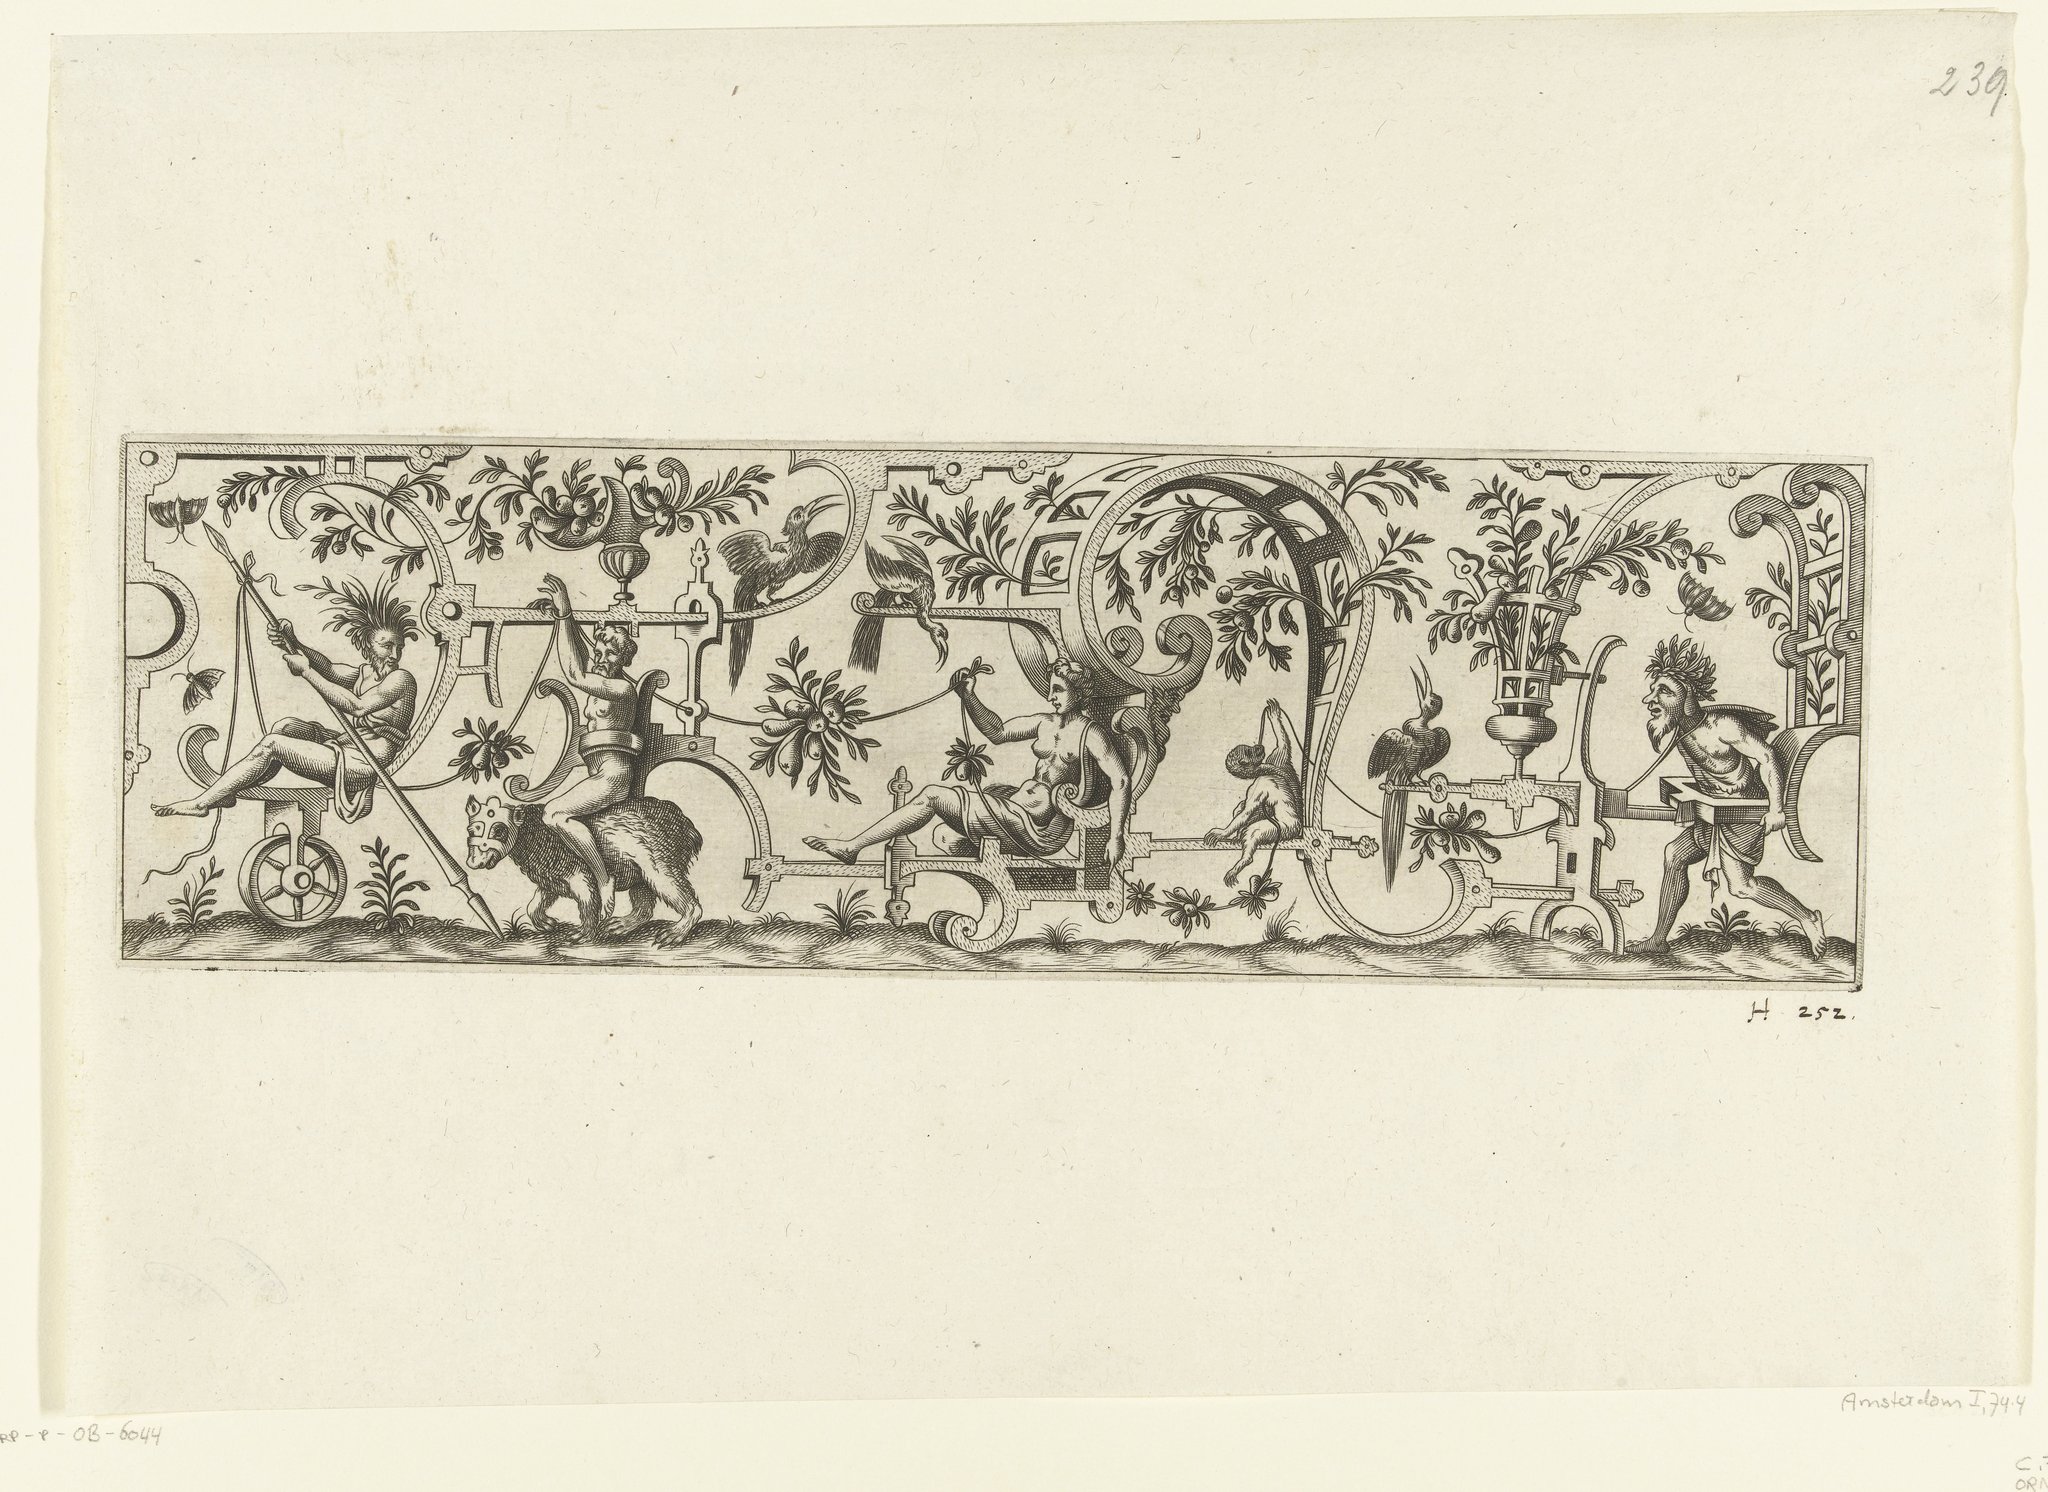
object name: ornament print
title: Wagen met een vrouw, geduwd door een man en getrokken door een man die op de rug van een beer rijdt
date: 1552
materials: paper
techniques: etching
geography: netherlands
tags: ornament ~ grotesque, chariot, triumphal car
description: Voorop zit een man met een lans. Achter de rug van de vrouw zit een aapje. Hoort bij serie van 4 bladen.